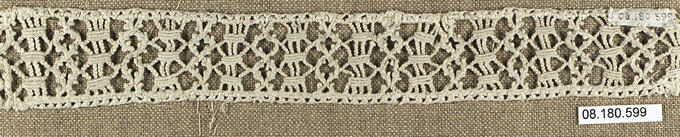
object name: border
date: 1601-1700